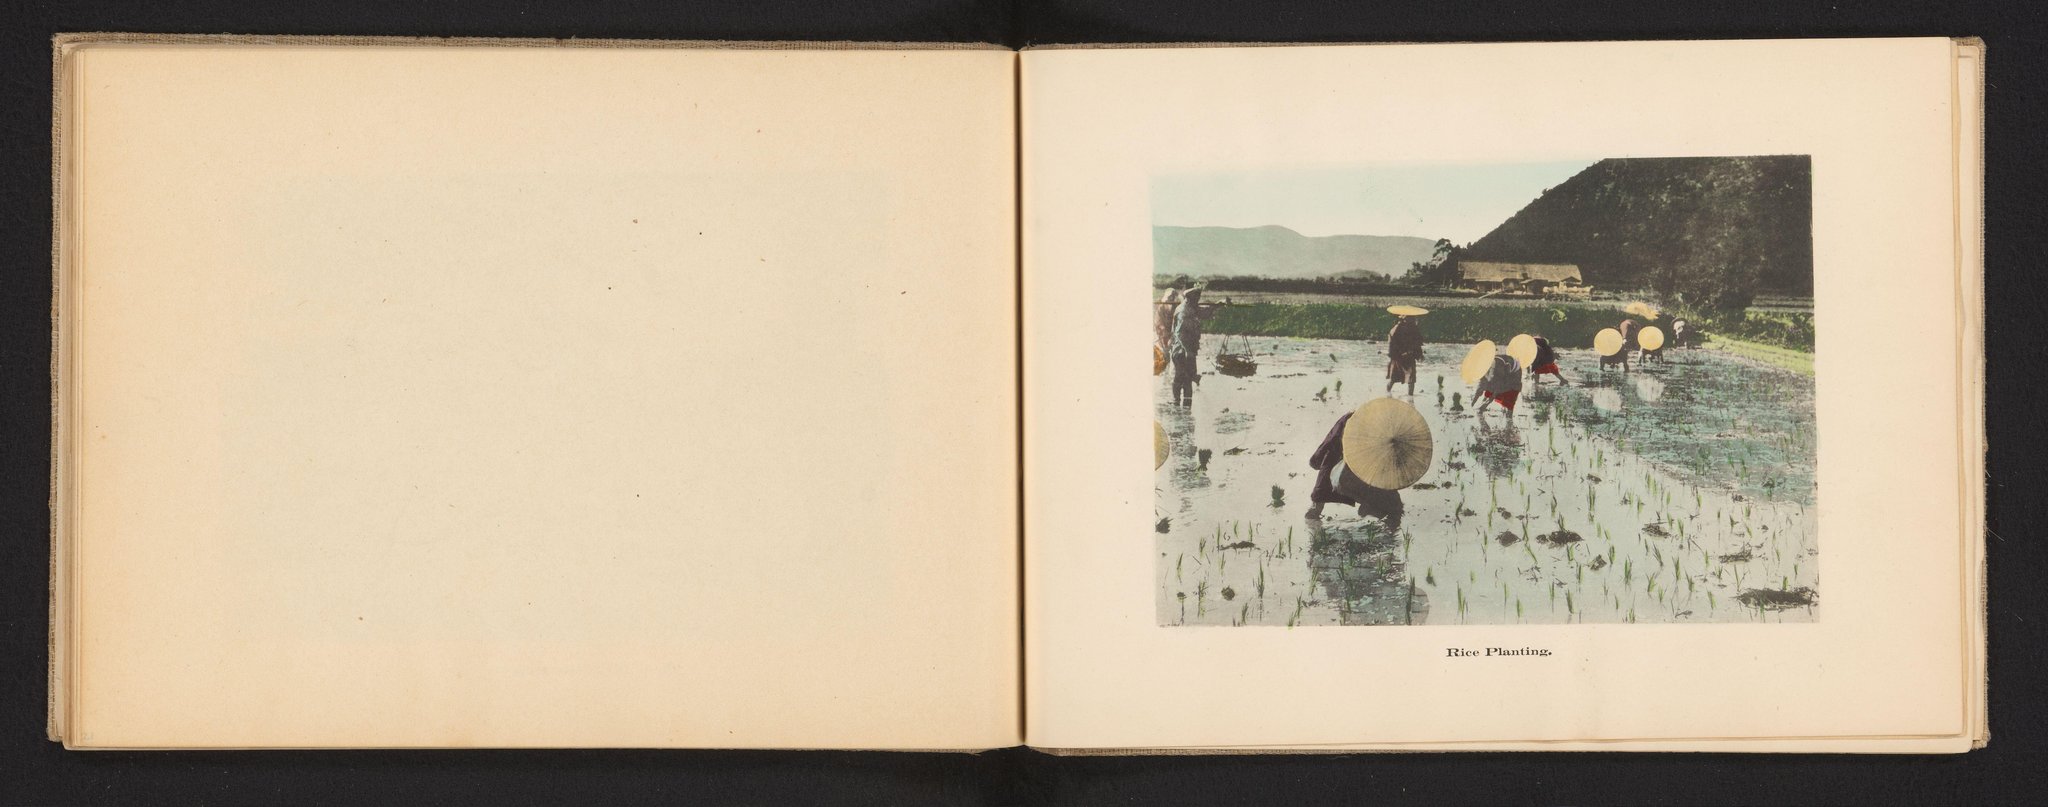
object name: photomechanical print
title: Mensen aan het werk op een rijstveld in Japan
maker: kōzaburō tamamura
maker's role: fotograaf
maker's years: 1856-1923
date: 1895-1905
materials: paper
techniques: photograph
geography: japan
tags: sawahs, rice paddies, japan